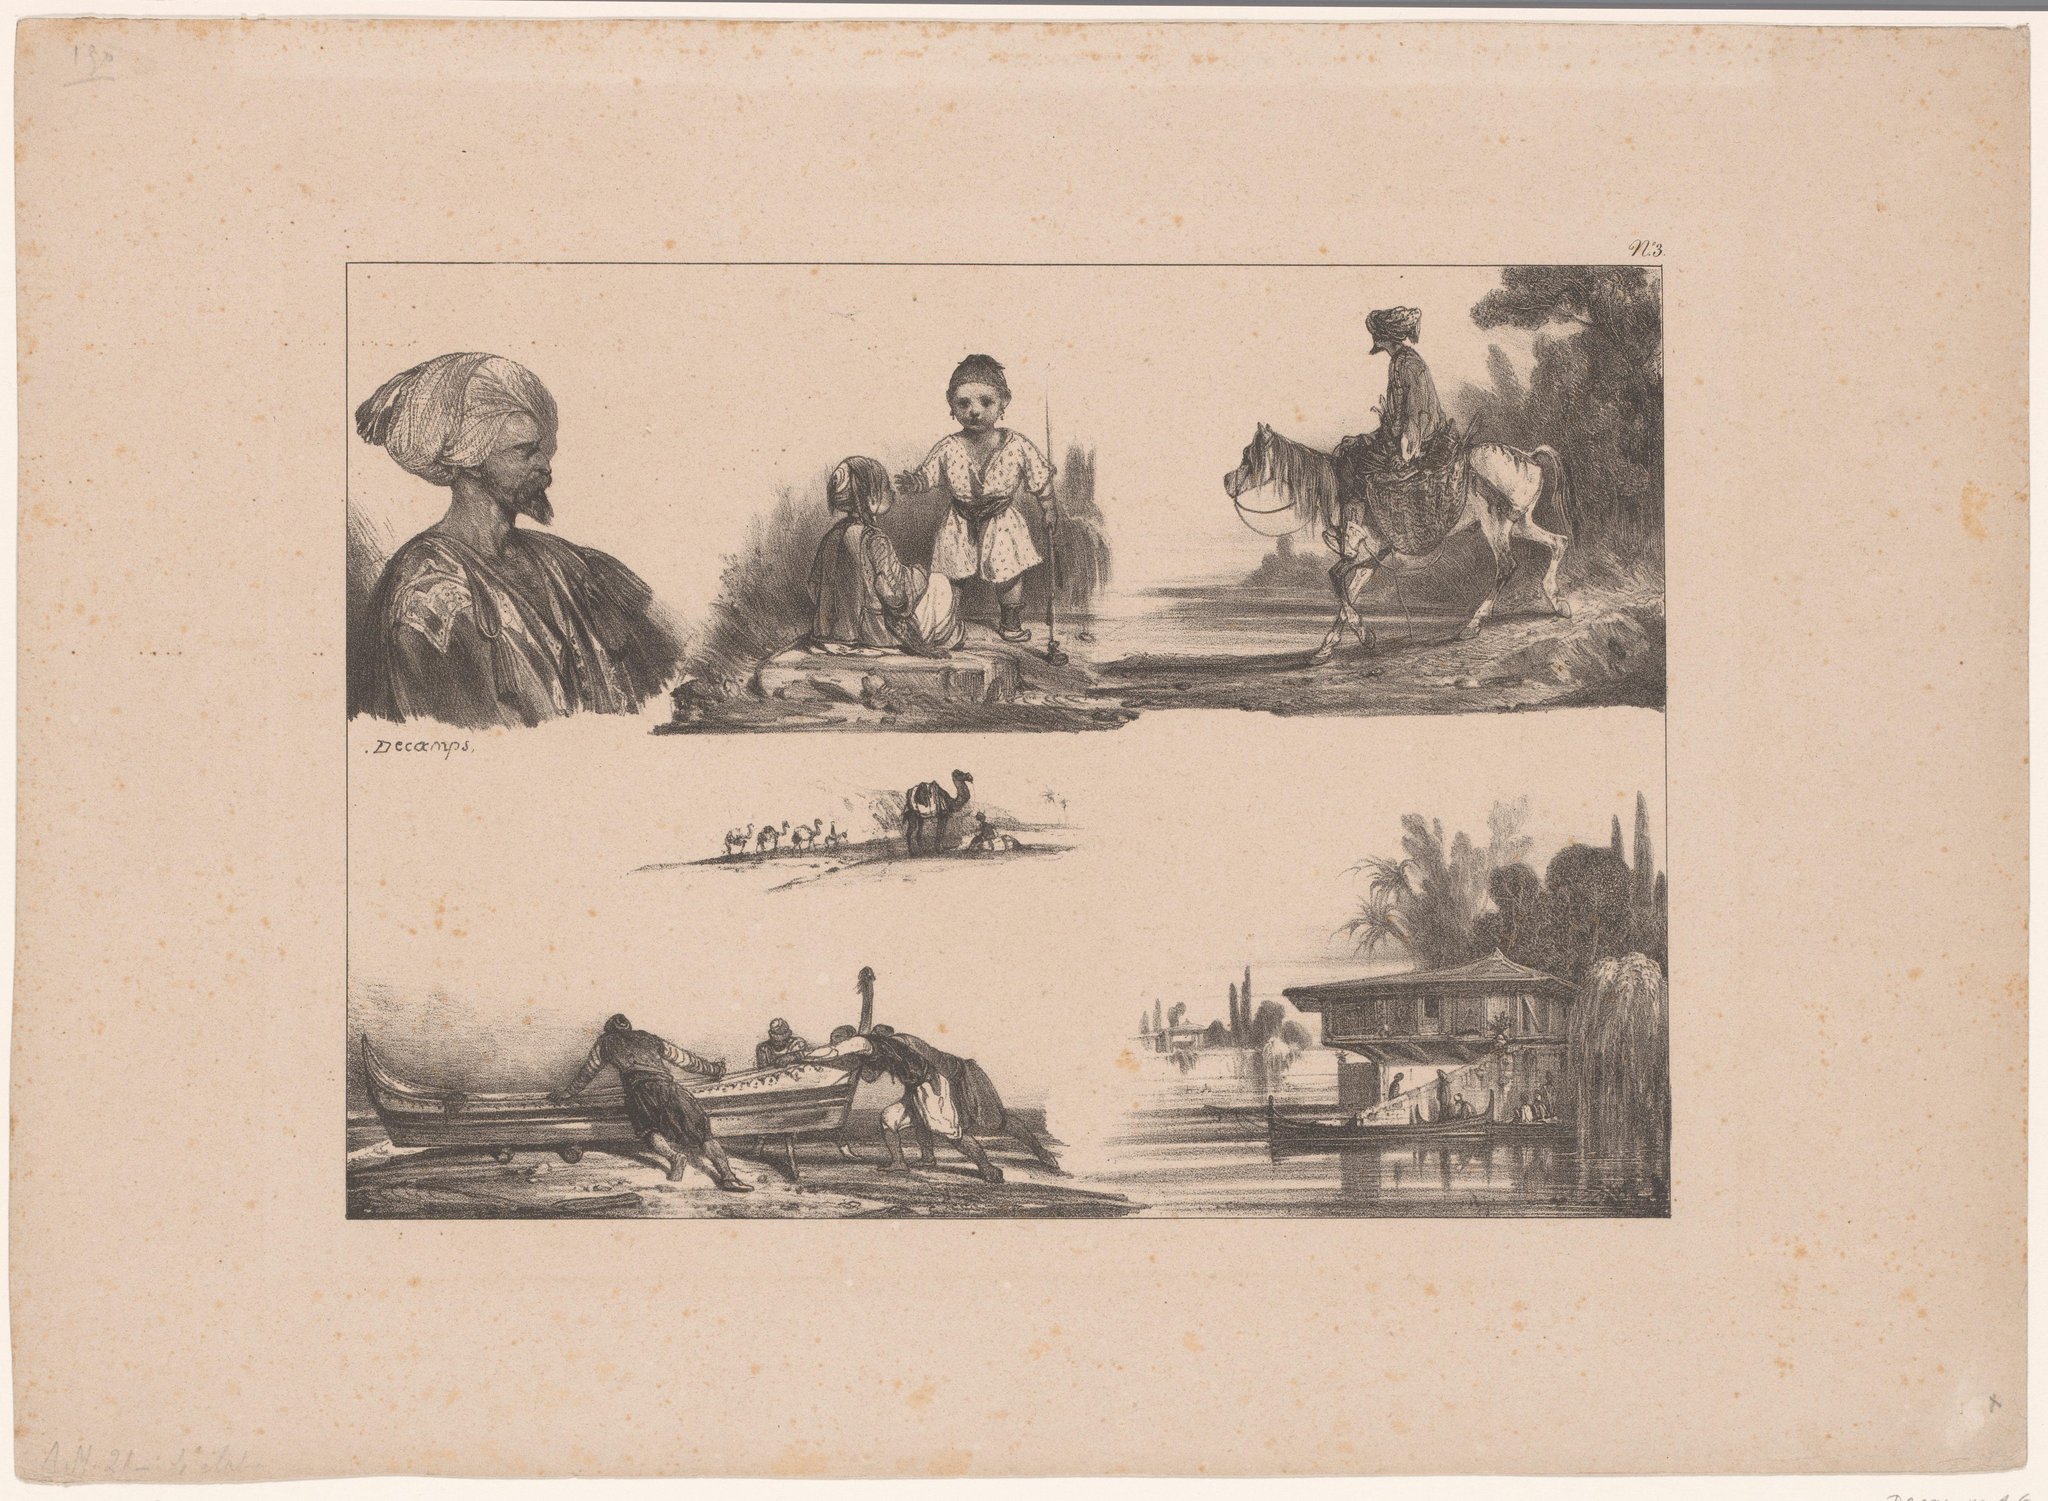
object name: print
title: Zes voorstellingen van oosterse figuren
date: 1829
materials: paper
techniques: lithograph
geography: paris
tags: riding a horse, ass, or mule; rider, horseman, child, head-gear: turban, boat propelled by man or animal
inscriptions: collector's mark: Lugt 2760, collector's mark: Lugt 2228a